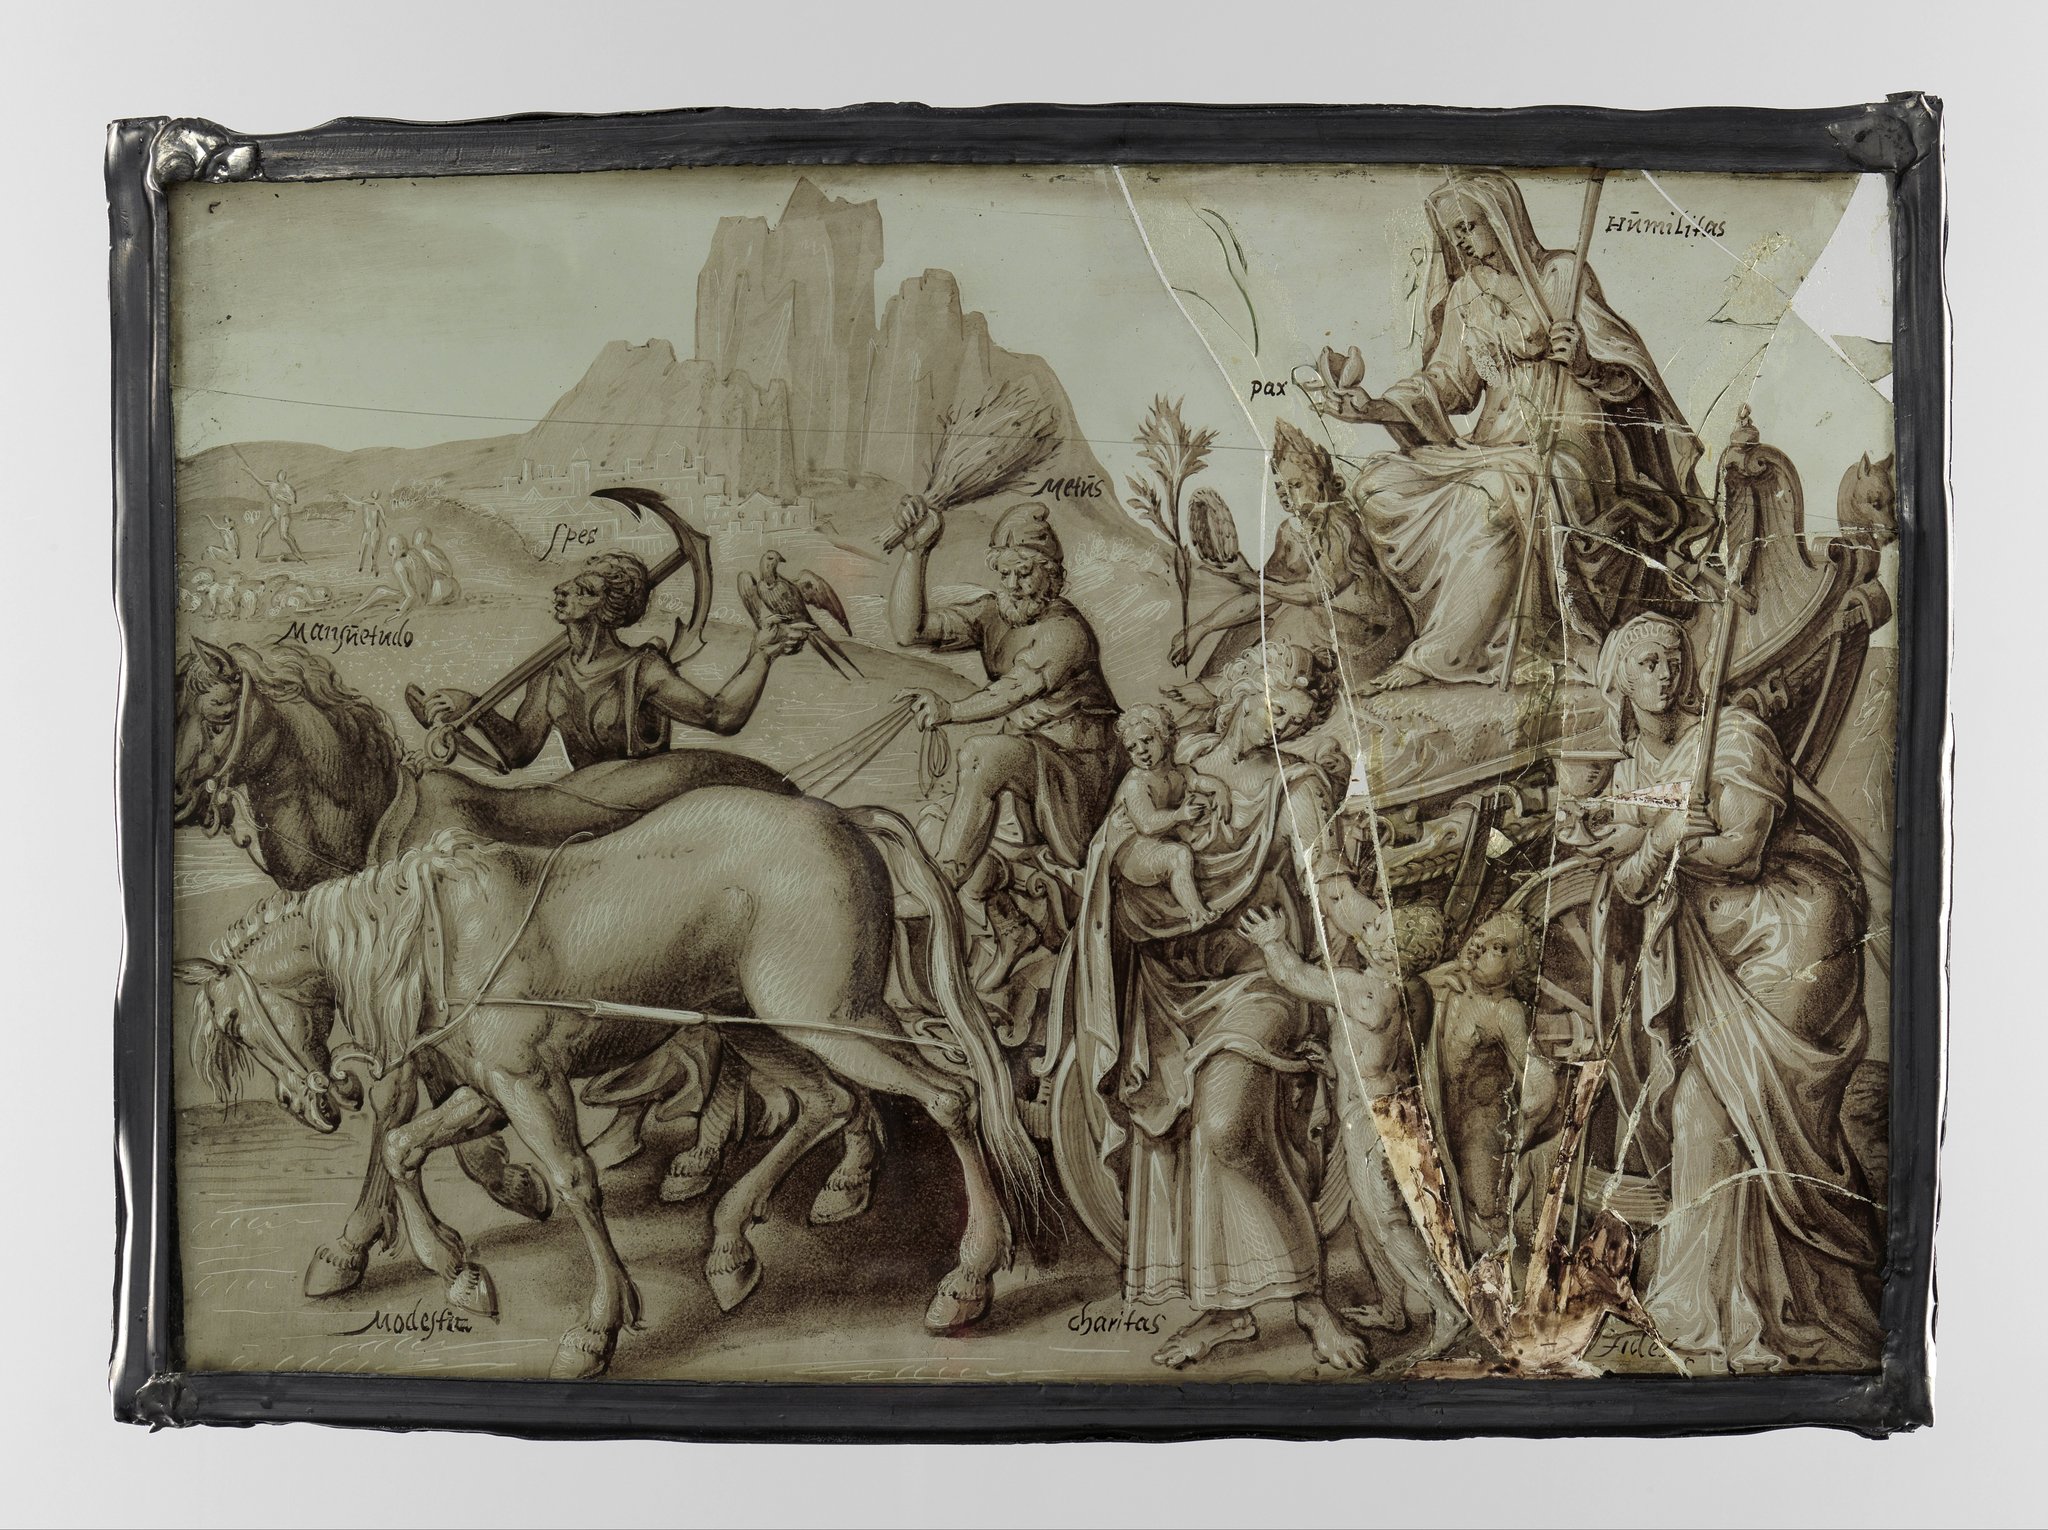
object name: light window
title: Ruit met De Triomf van de Nederigheid (Humilitas)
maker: Anonymous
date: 1575-1600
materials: glass, lead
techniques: leading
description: Ruit met De Triomf van de Nederigheid. Humilitas in een kar.